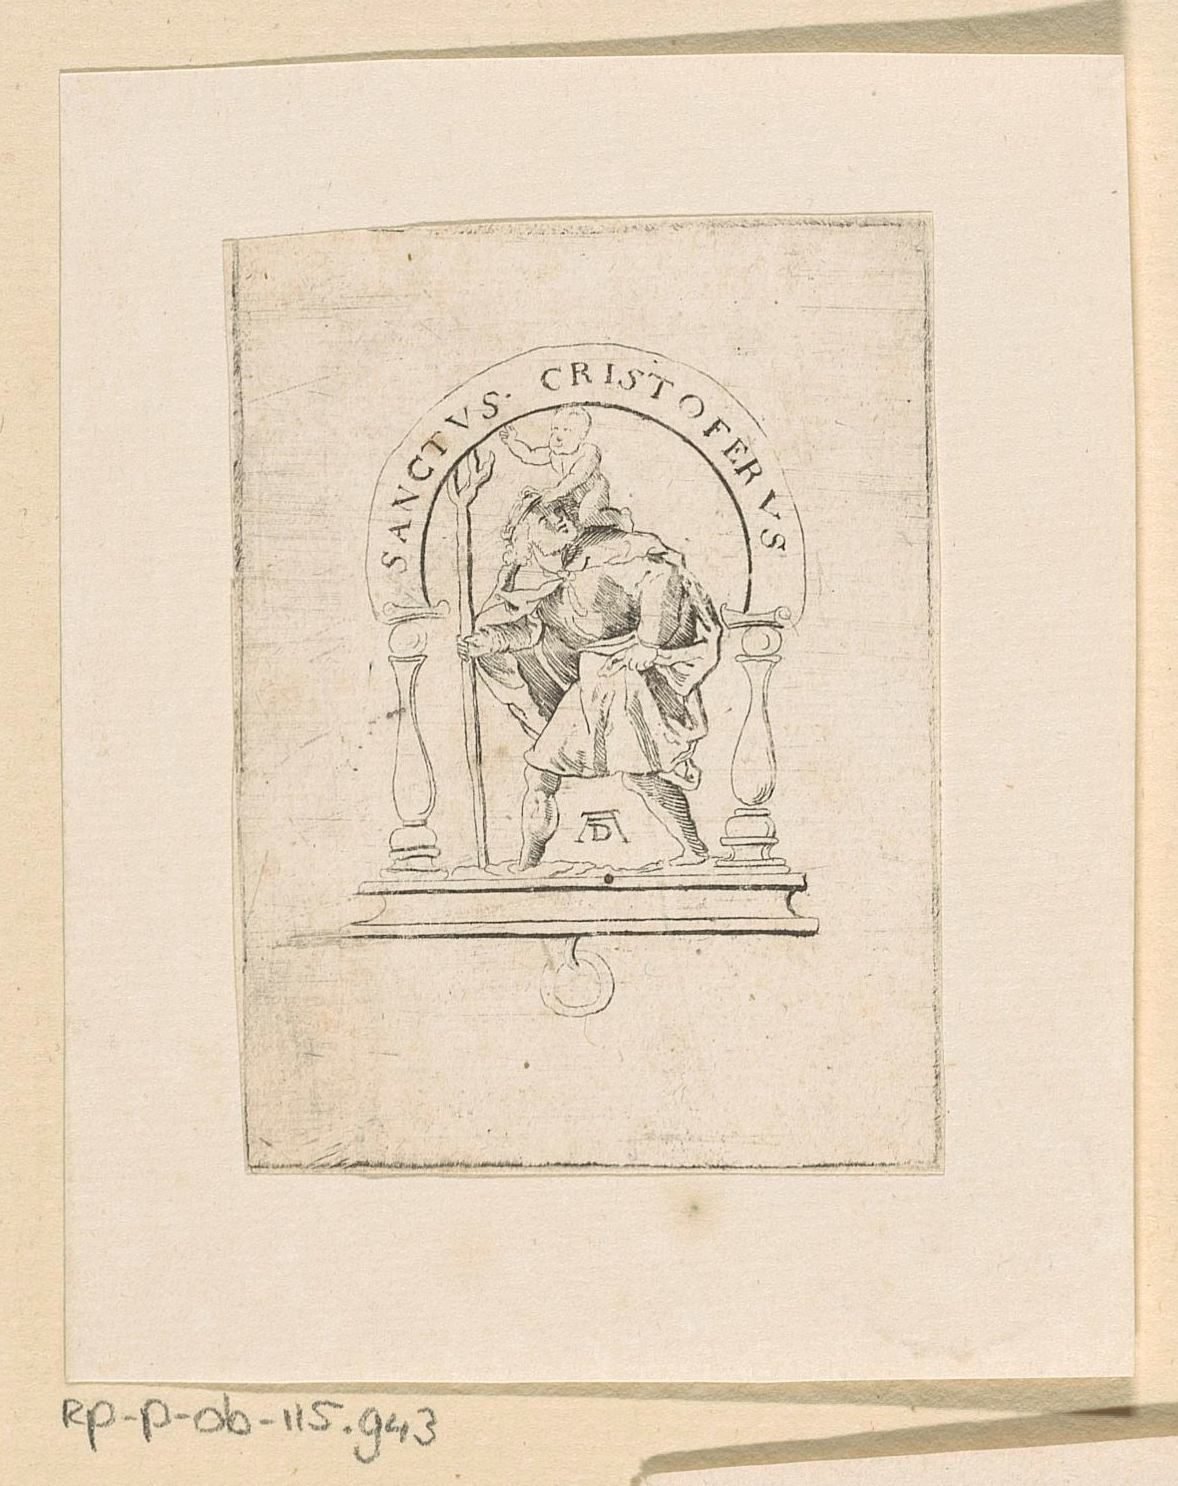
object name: print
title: Heilige Christoffel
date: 1600-1699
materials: paper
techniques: etching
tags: arch, archivolt ~ architecture, the giant and martyr christophorus; possible attributes: palm-tree (with bunches of dates, or withered), infant christ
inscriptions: collector's mark (): Lugt 240, monogram (false): ‘AD’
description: Mogelijk naar ontwerp van Albrecht Dürers houtsnede van de Heilige Christoffel uit de Salus Animae reeks.